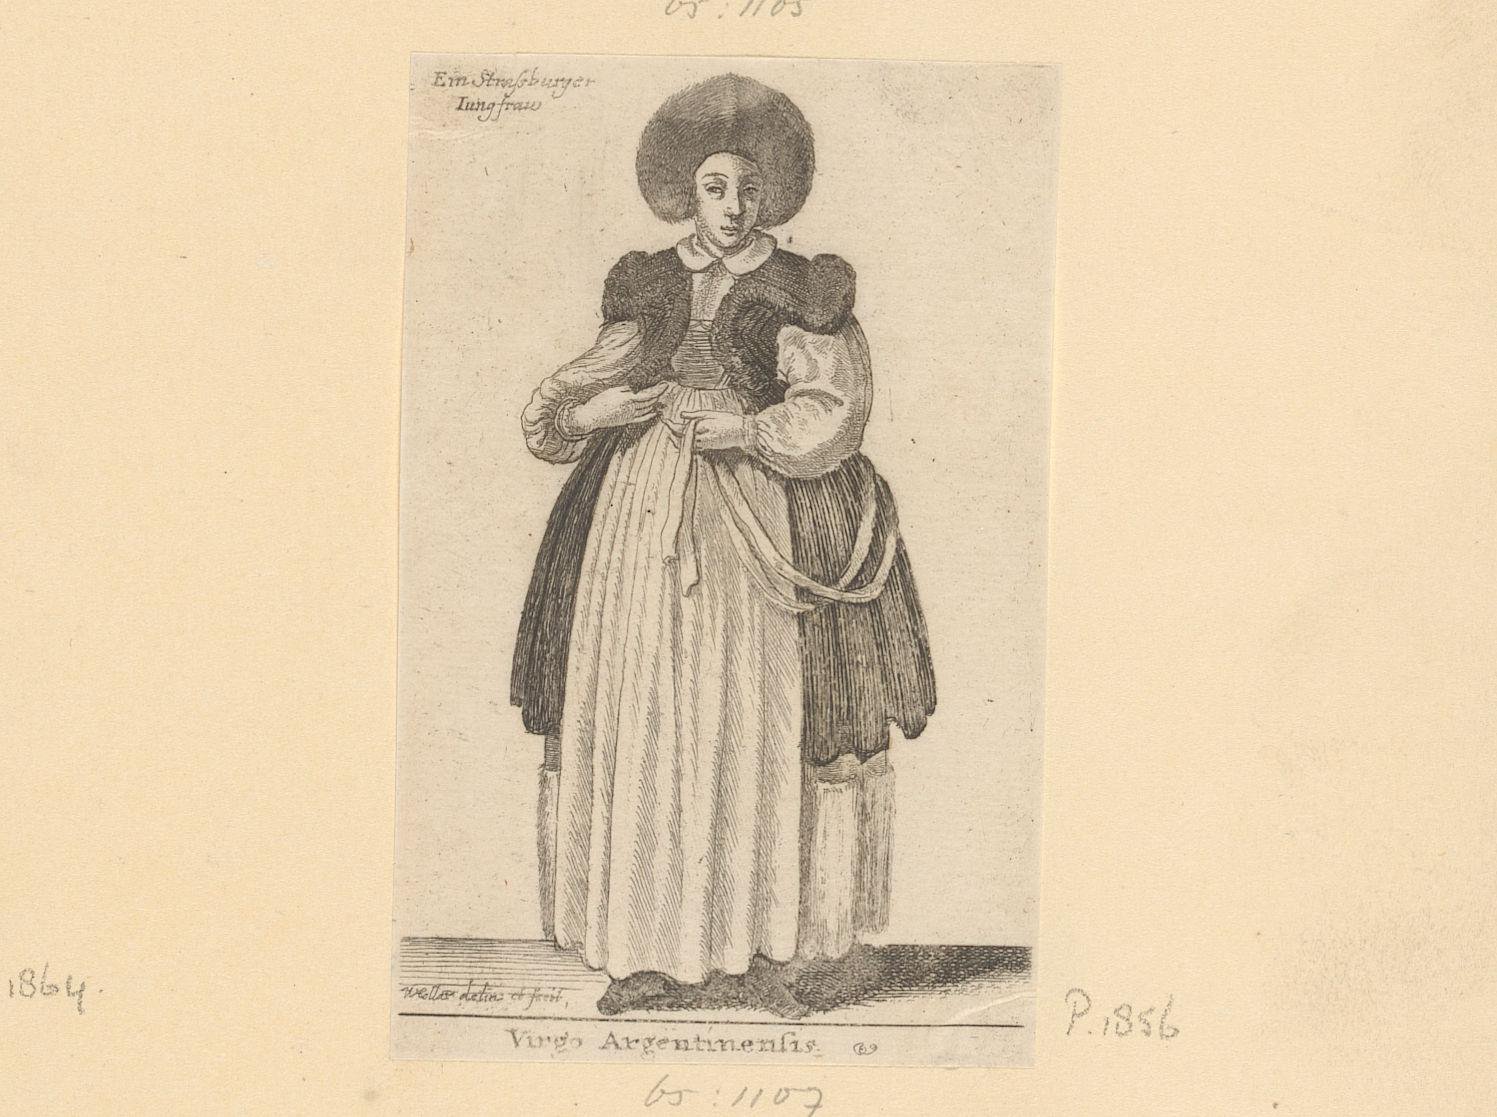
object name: album leaf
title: Vrouw in klederdracht uit Straatsburg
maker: wenceslaus hollar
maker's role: draughtsman, print maker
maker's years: 1607-1677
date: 1643-1649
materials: paper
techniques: etching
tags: adult woman, folk costume, regional costume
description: Prent maakt mogelijk deel uit van een serie van 200 prenten. Deze serie is onder de titel 'A Collection of two hundred original etchings' voor het eerst uitgegeven door J.M. Greery in 1816.